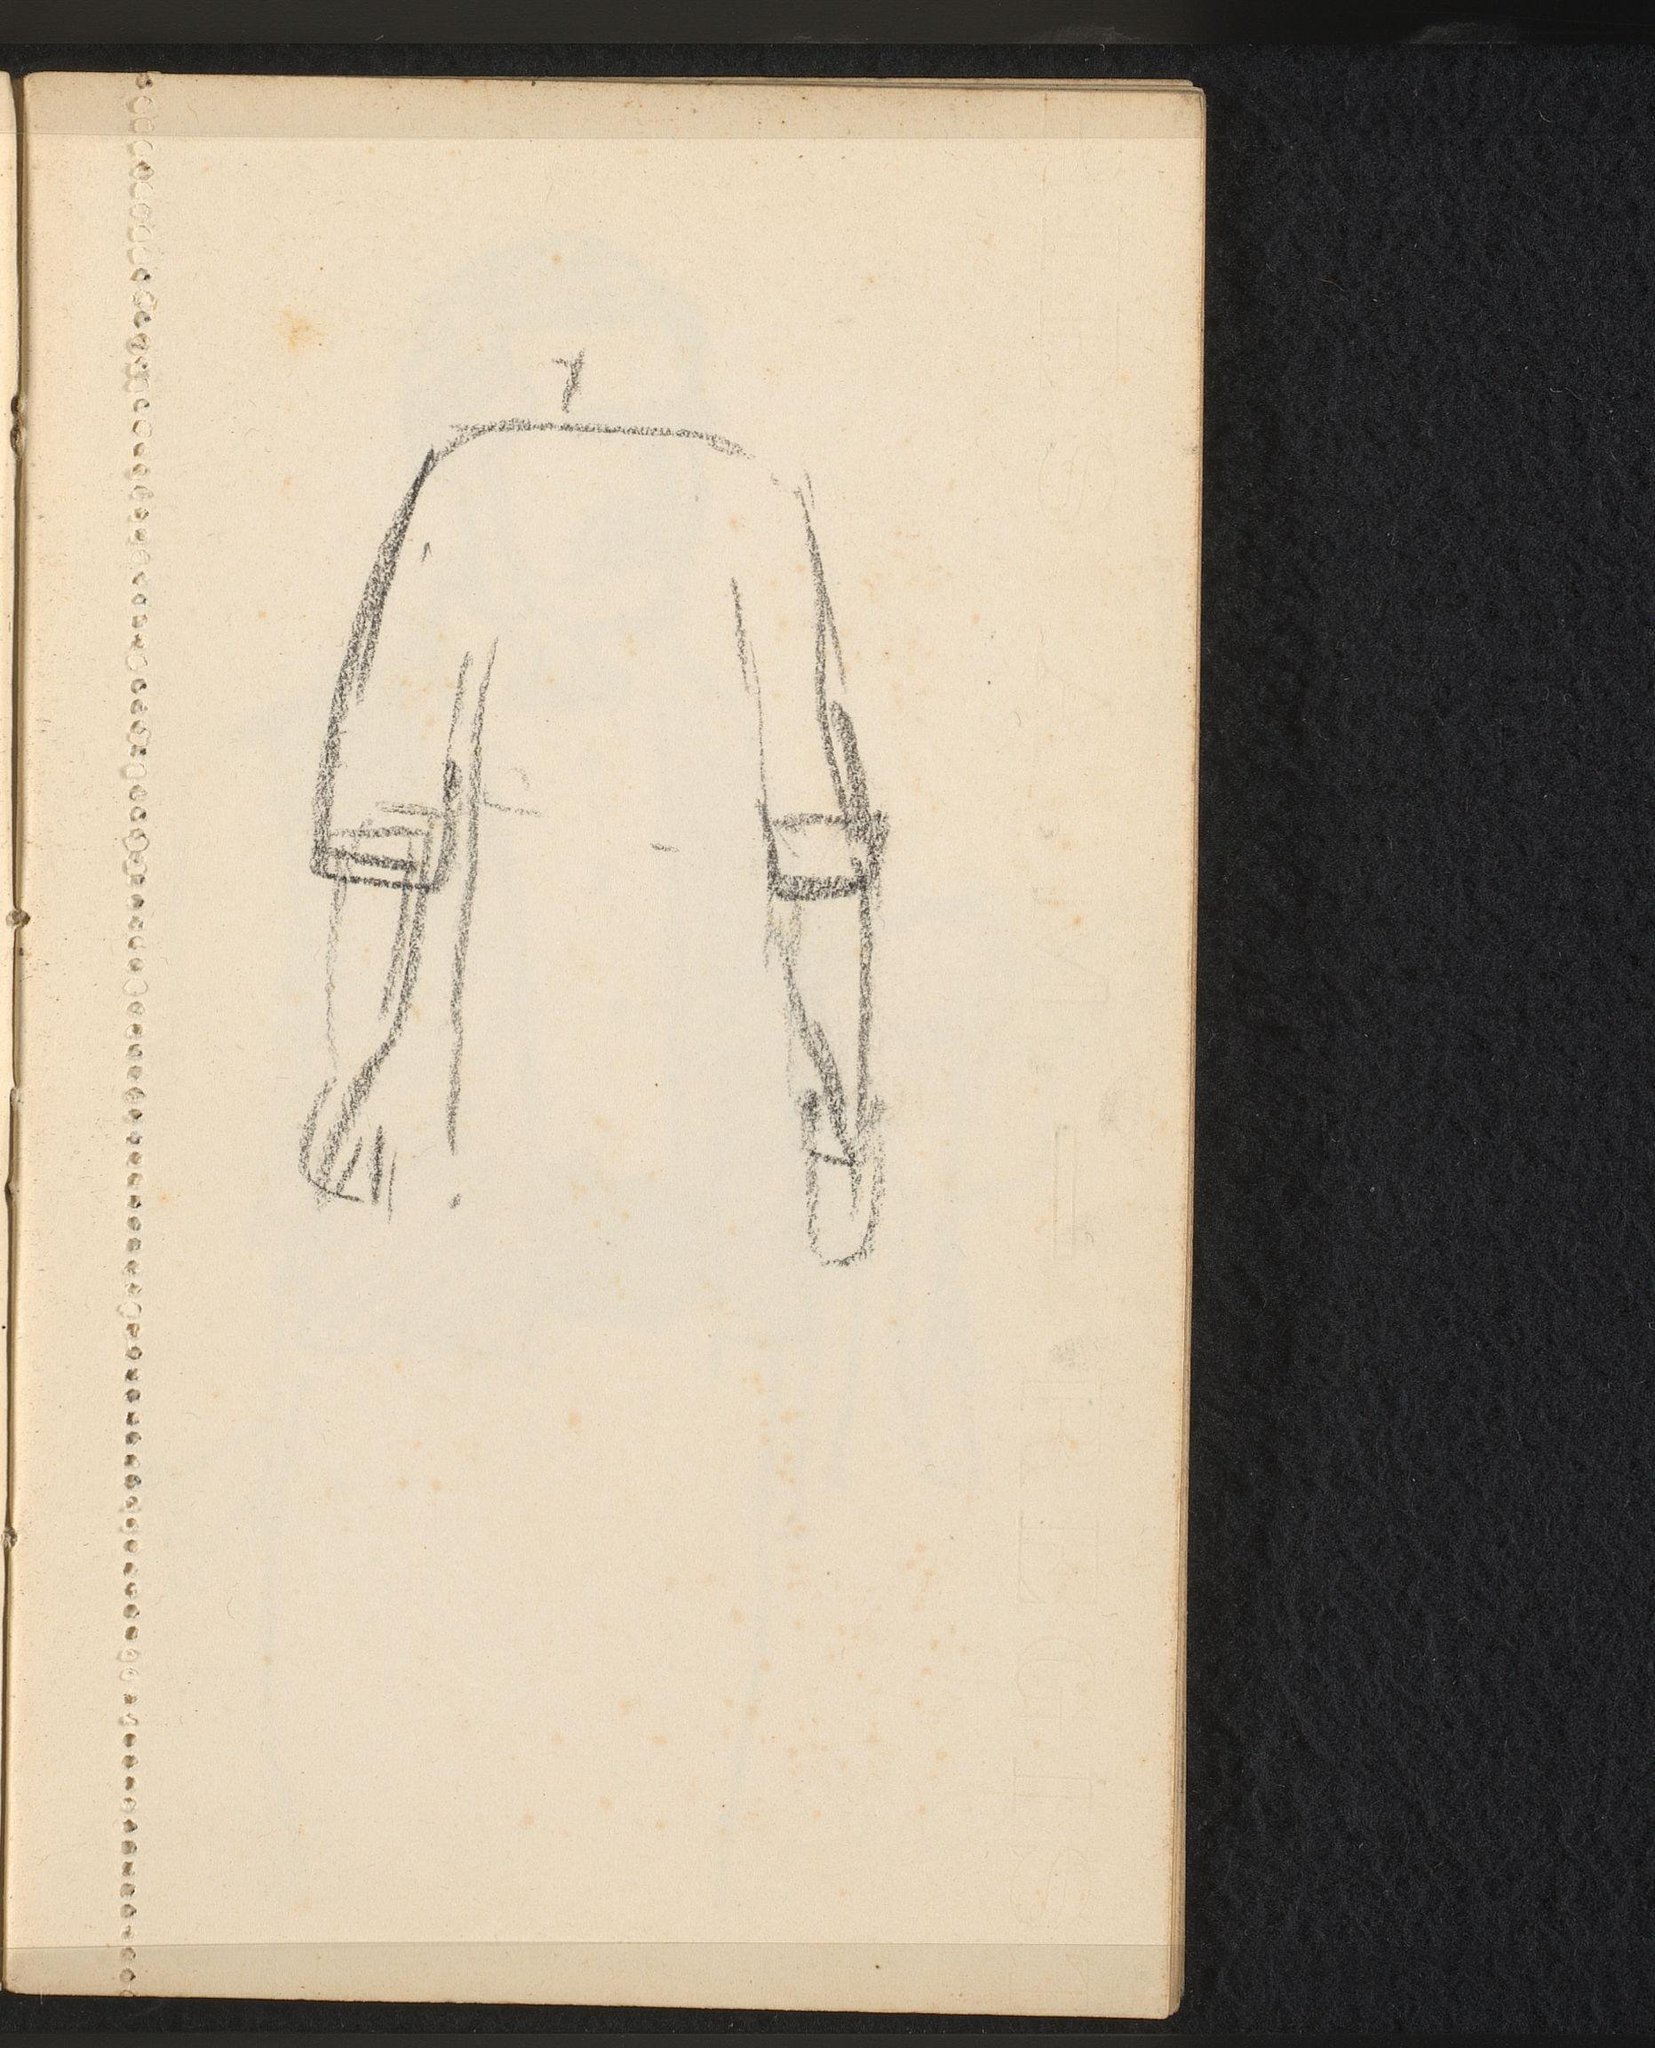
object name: sketchbook leaf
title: Rug van een man met opgestroopte hemdsmouwen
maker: gerrit van blaaderen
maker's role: draughtsman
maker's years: 1873-1935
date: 1908-1927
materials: chalk, paper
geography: france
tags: sleeves, adult man (+ back view)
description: Blad 21 recto uit een schetsboek met 33 bladen.